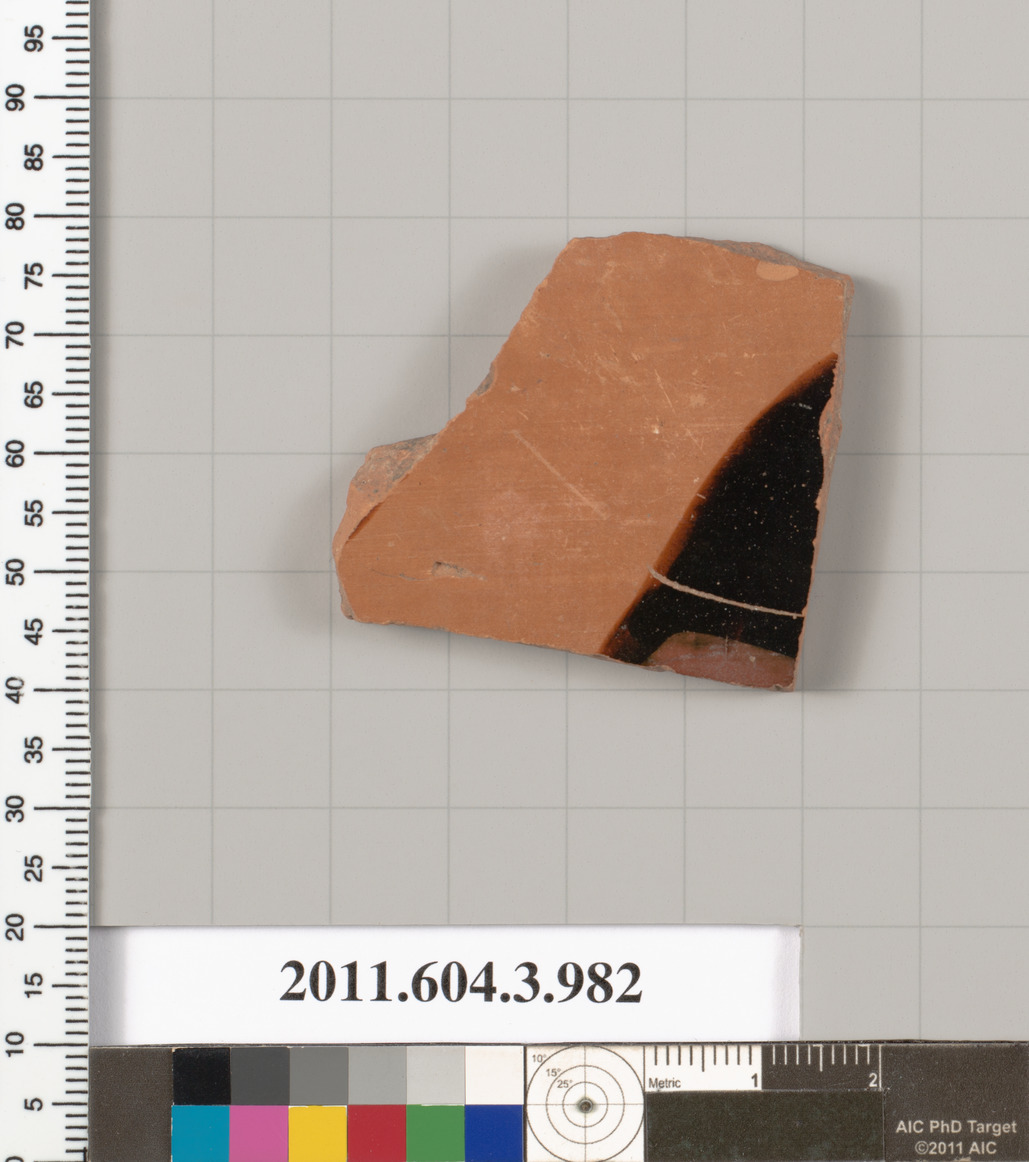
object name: lekanis lid fragment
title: Terracotta fragment of a lekanis lid (covered dish)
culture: greek, attic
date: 575-551 BCE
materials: terracotta